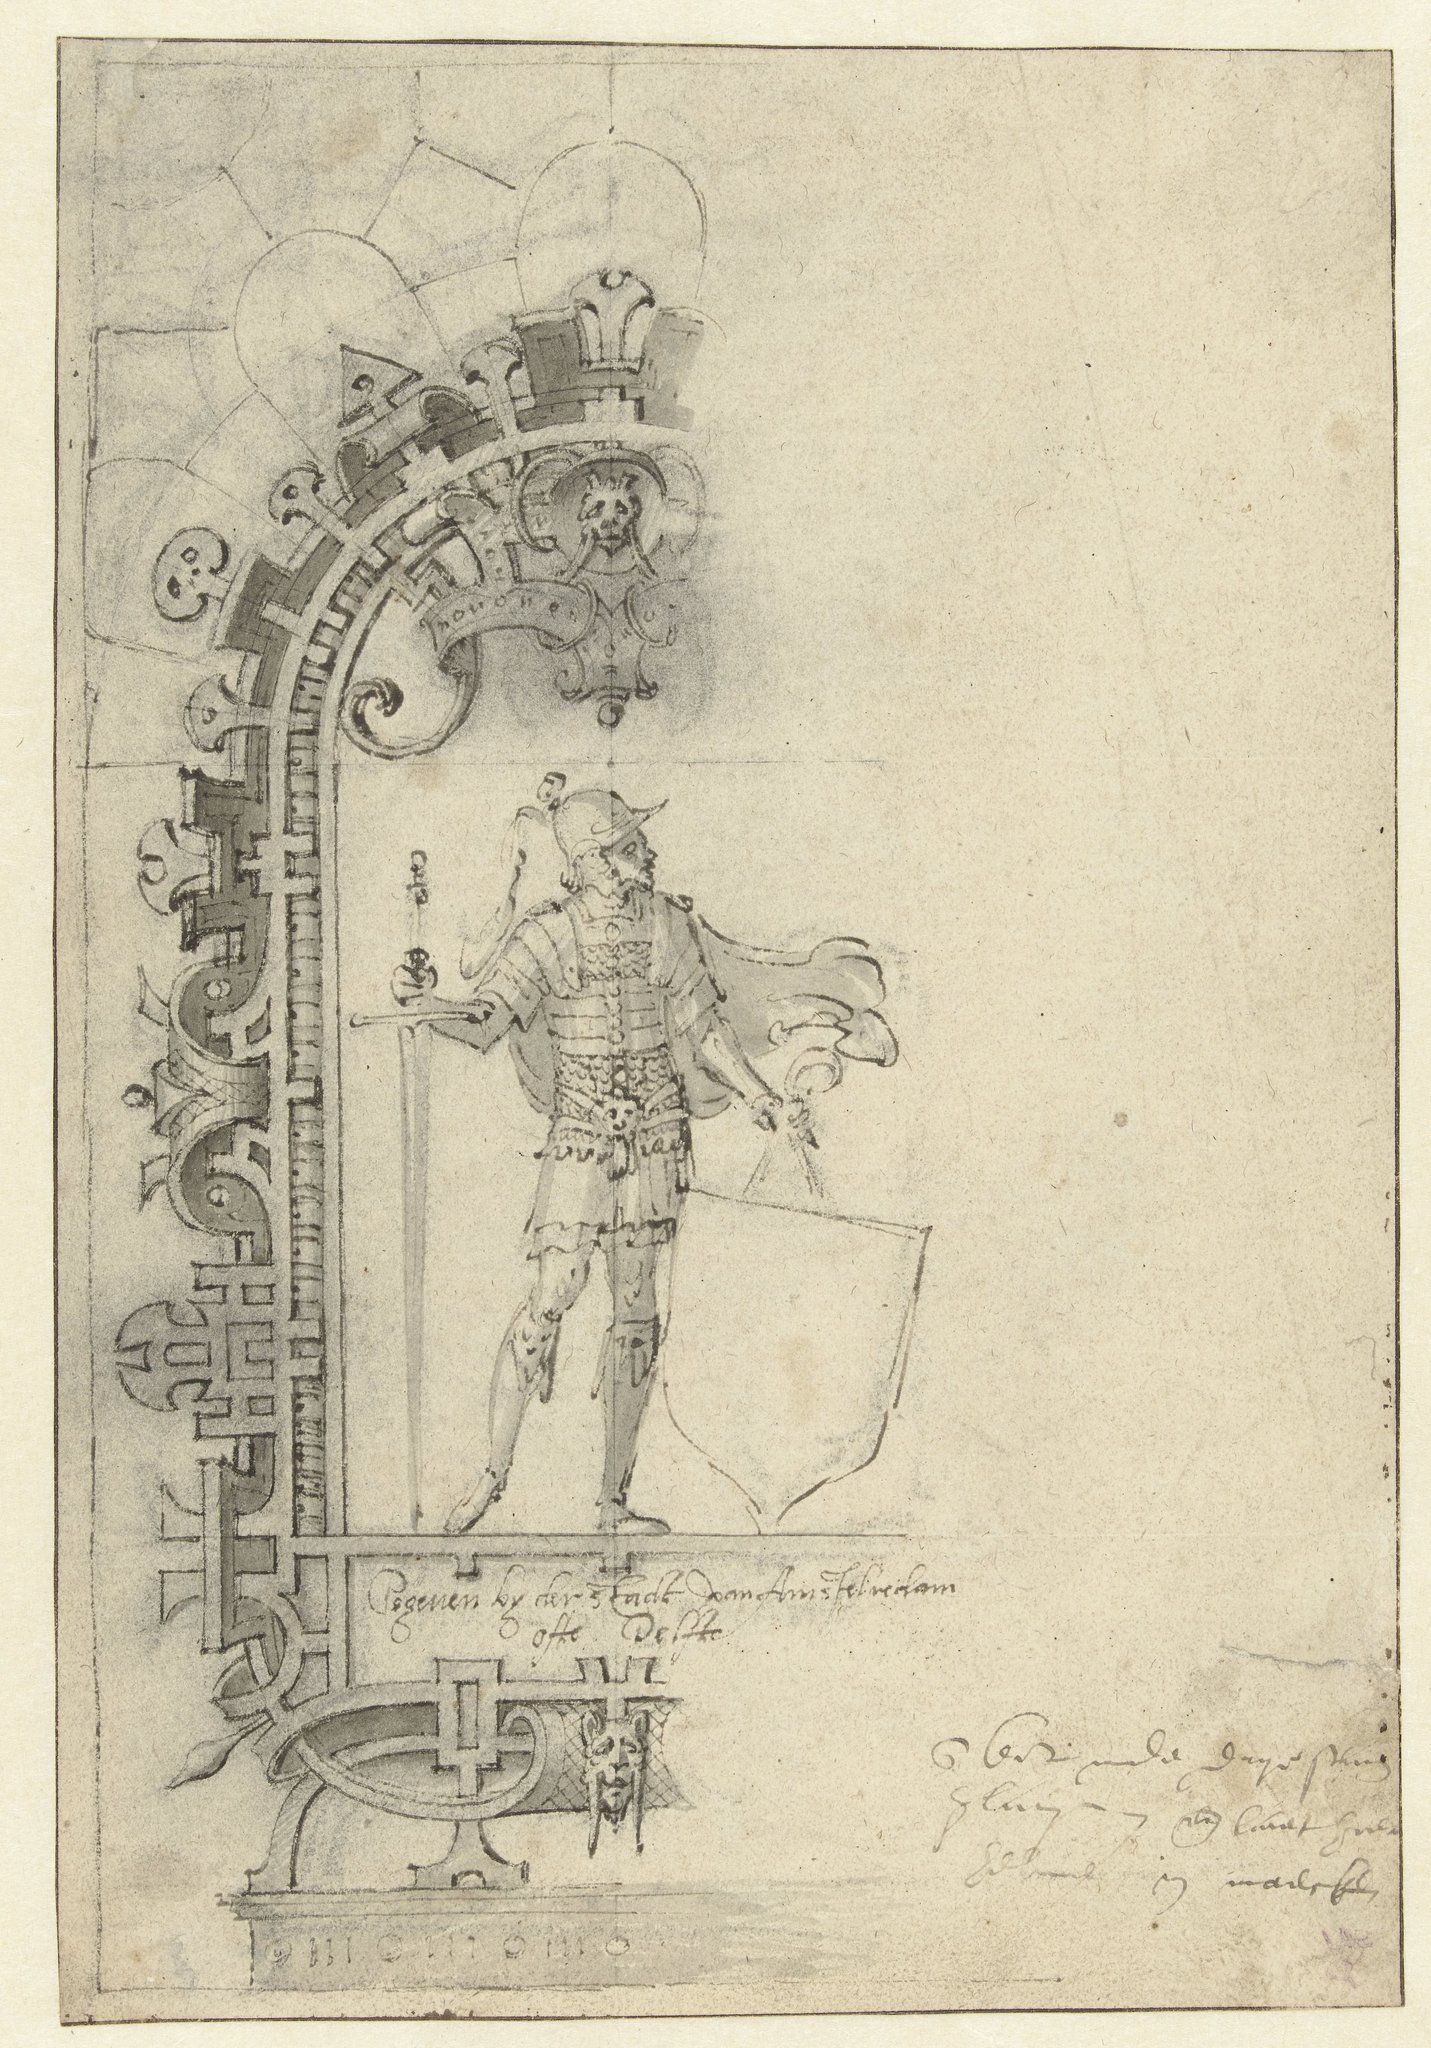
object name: design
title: Wapenschilddrager in een cartouche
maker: dirck pietersz. crabeth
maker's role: draughtsman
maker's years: 1520-1574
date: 1545-1574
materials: chalk, ink, paper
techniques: brush, pen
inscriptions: inscription: ‘midden onder de figuur geannoteerd: Gegeven by der stadt van Amstelredam/ ofte Delft. R.o. geannoteerd: verbeter(?)in de drye staende/ glaesen ende laet hier/ helmen in maecken’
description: Ontwerp voor een gebrandschilderd raam met een wapenschilddrager in een cartouche.